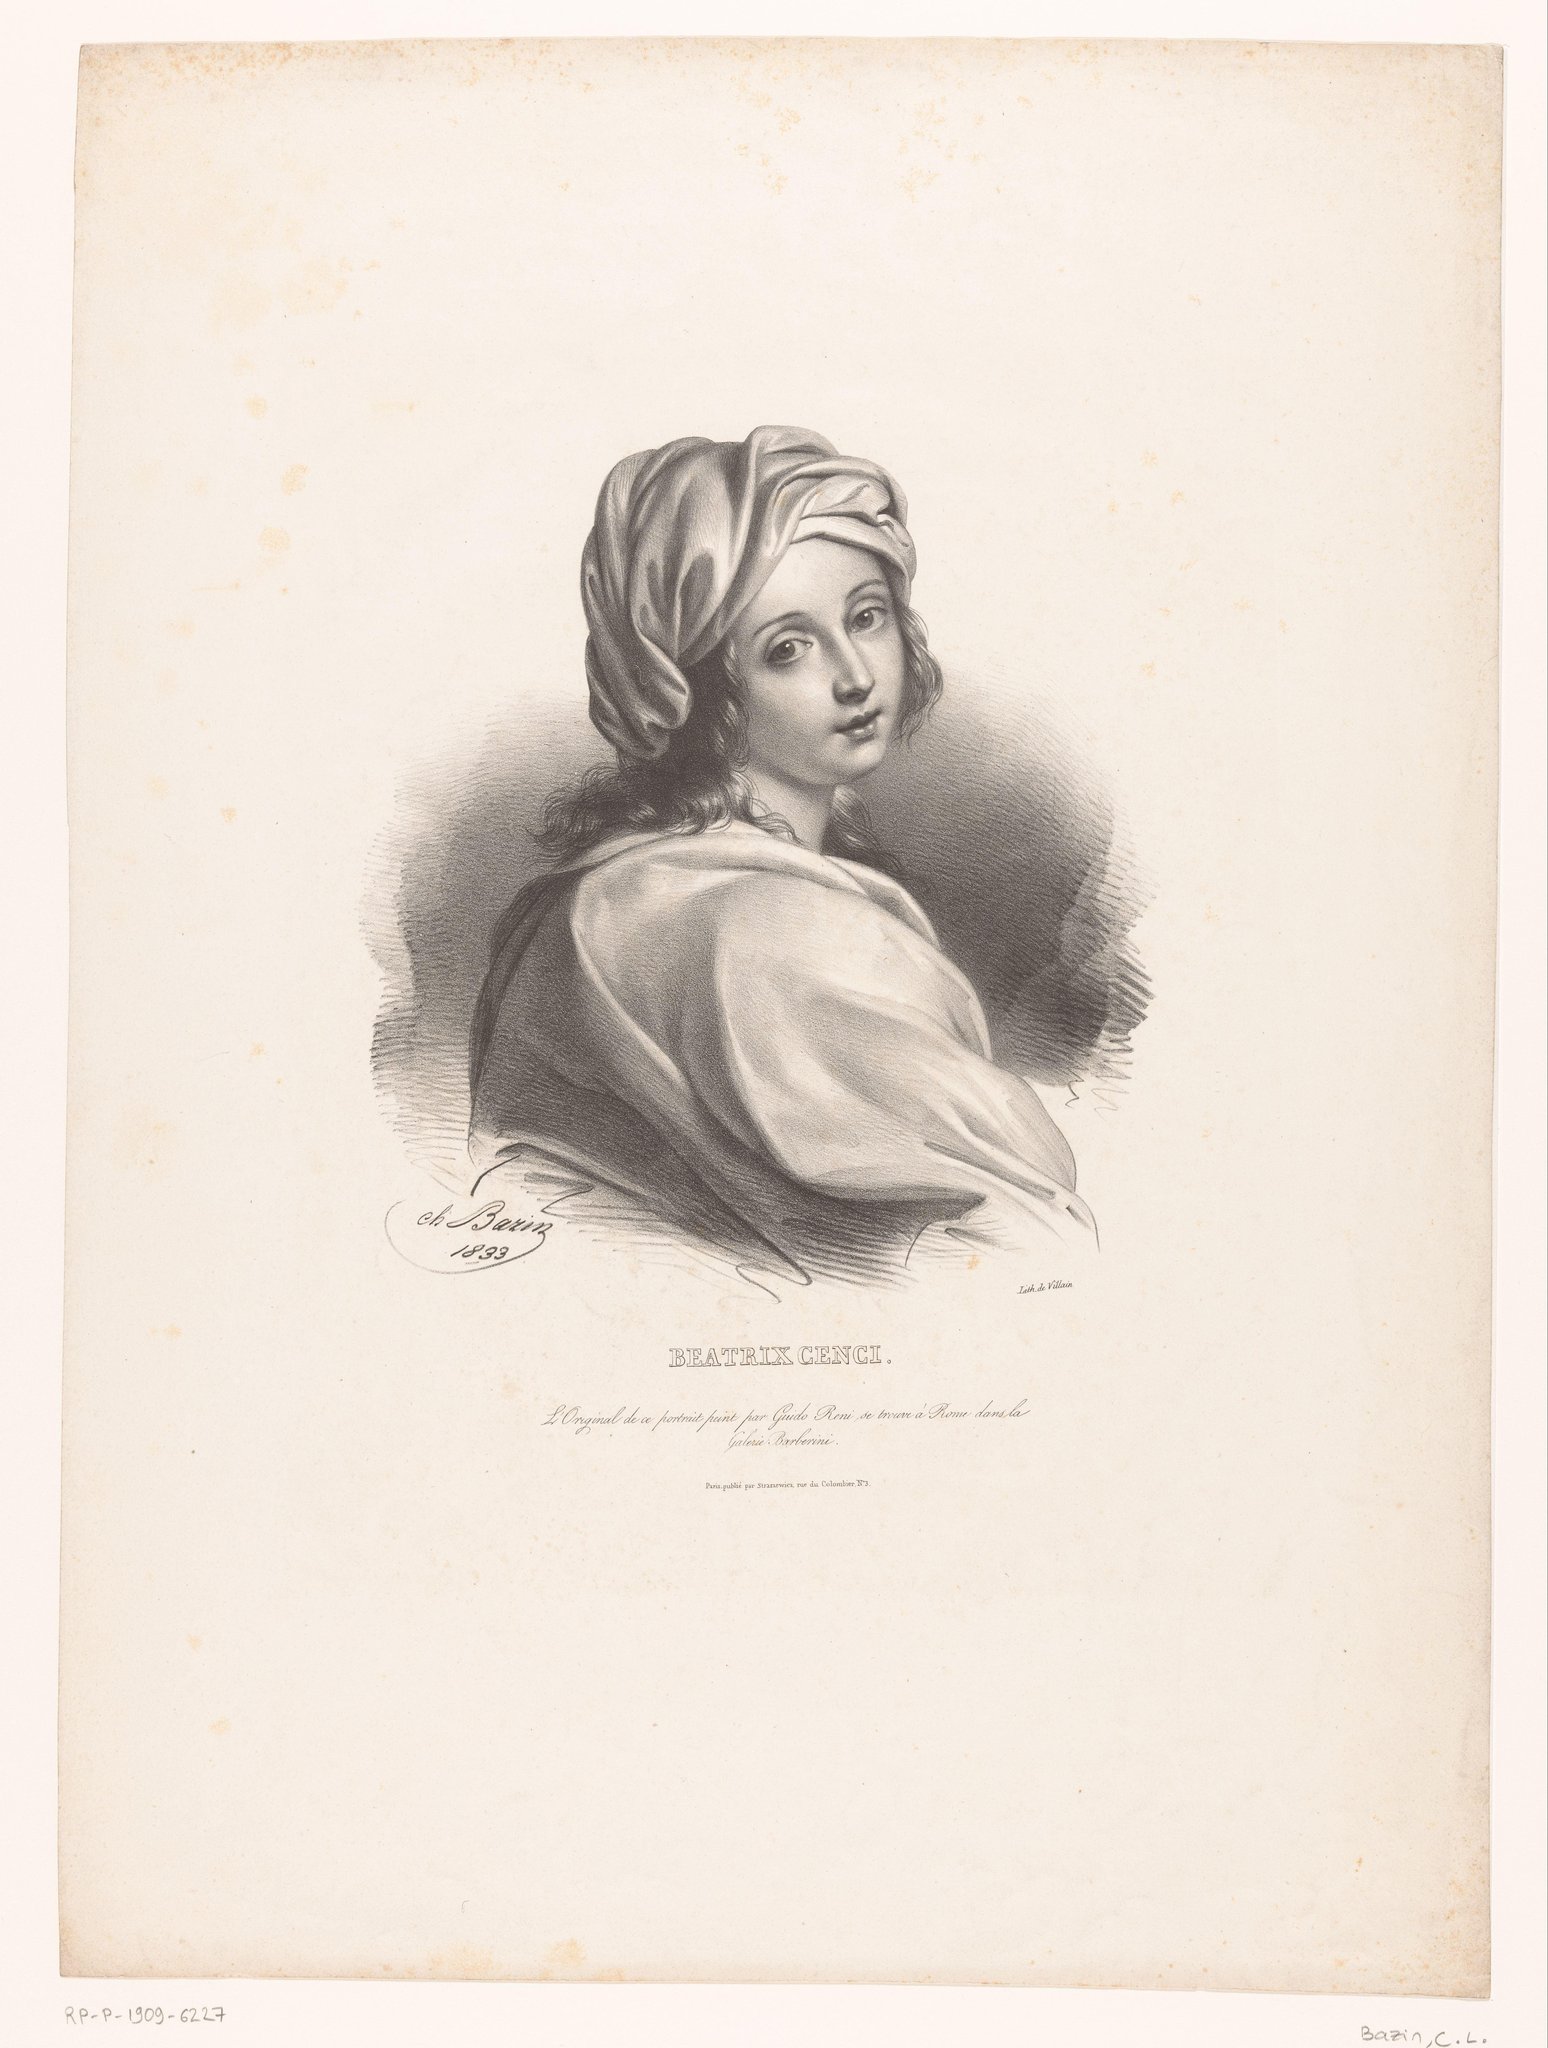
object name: print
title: Portret van de Romeinse edelvrouw Beatrice Cenci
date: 1833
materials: paper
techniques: lithograph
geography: paris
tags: historical persons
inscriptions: collector's mark: Lugt 2228a